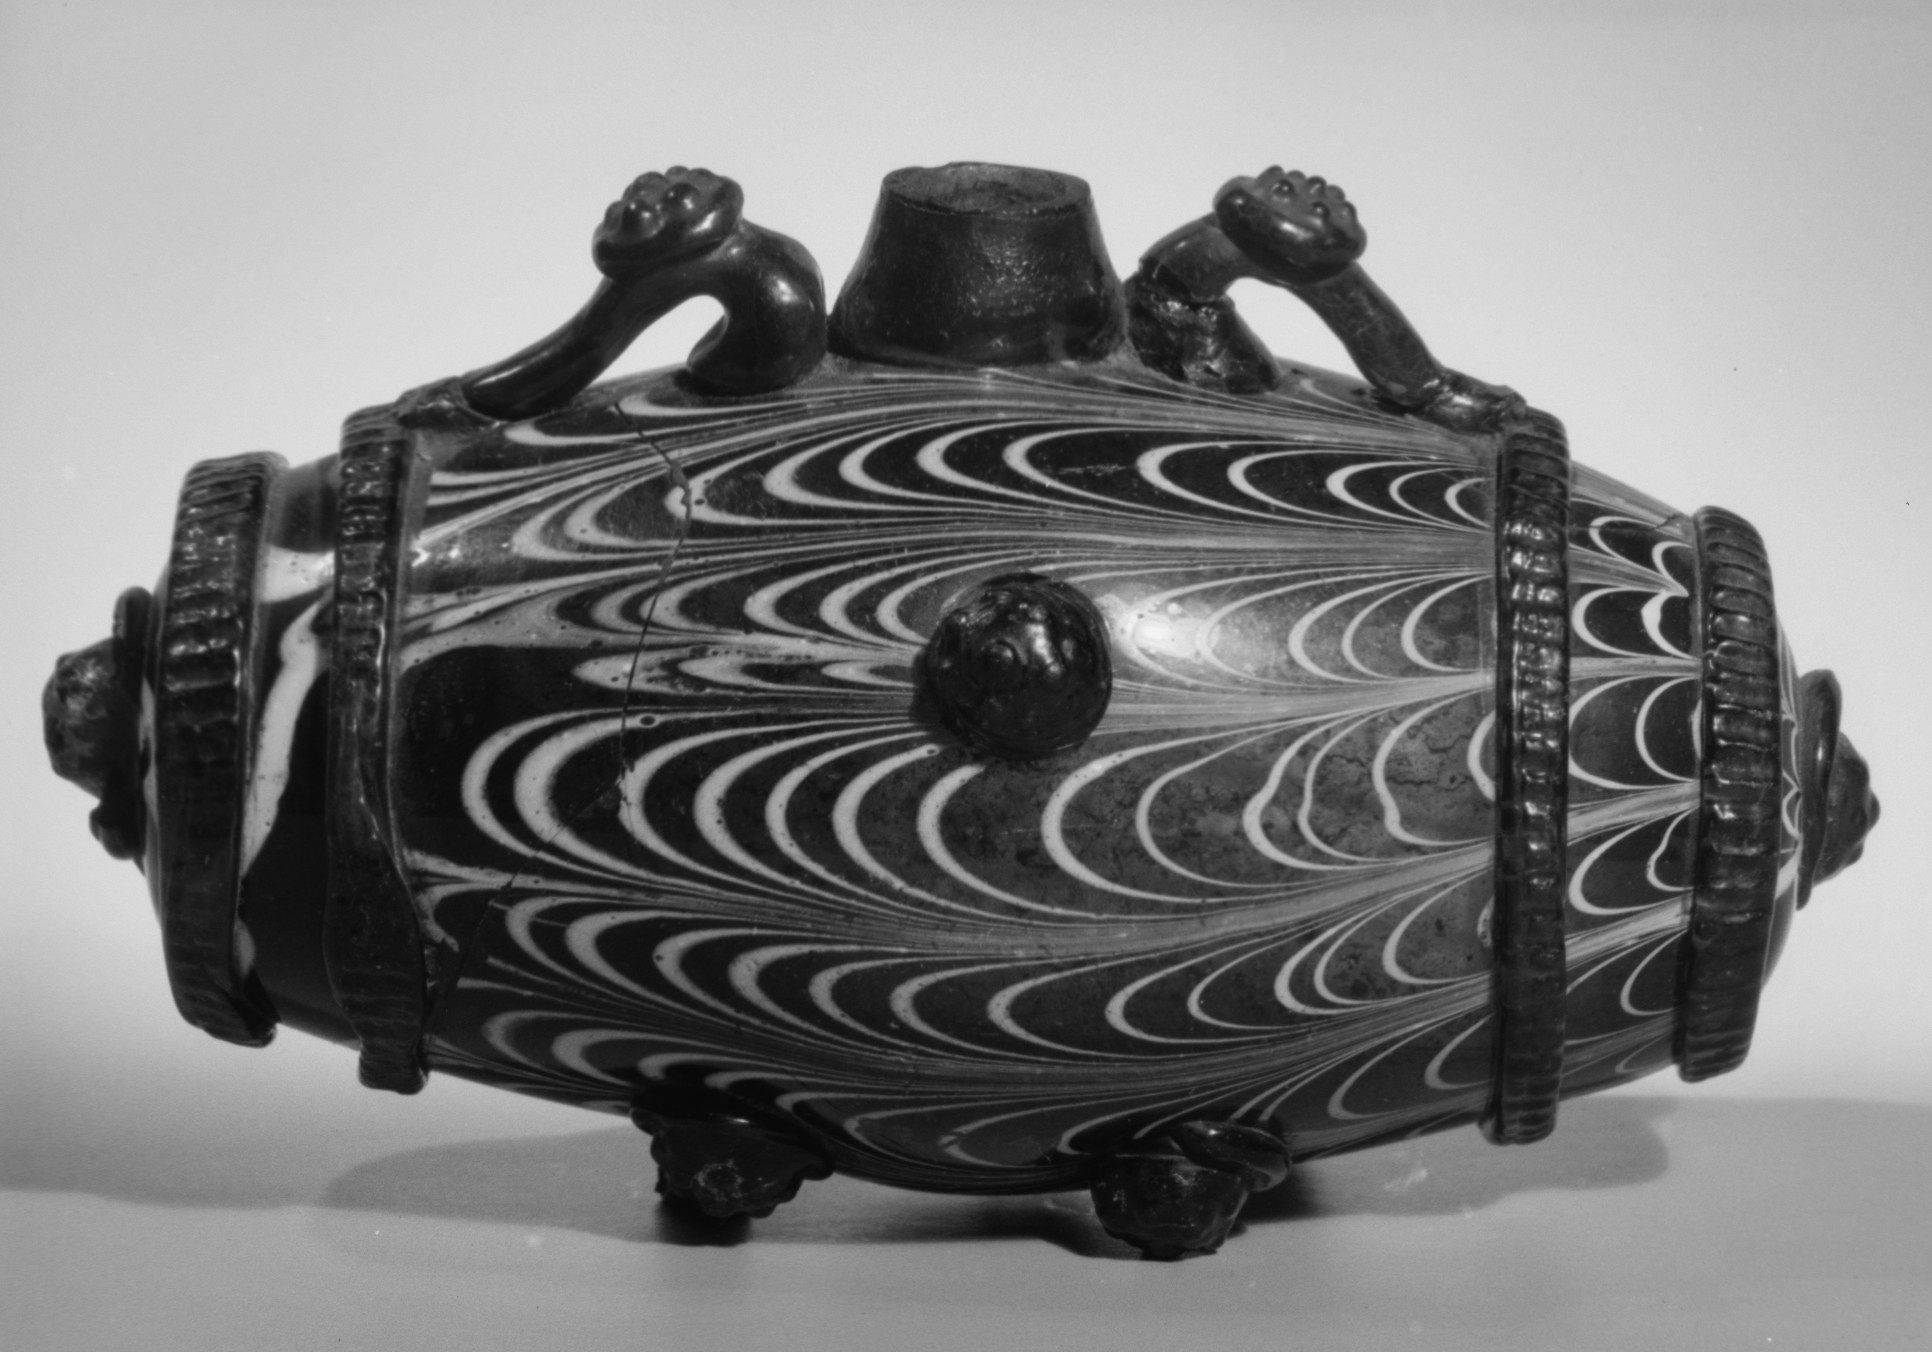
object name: flask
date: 1601-1700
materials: glass